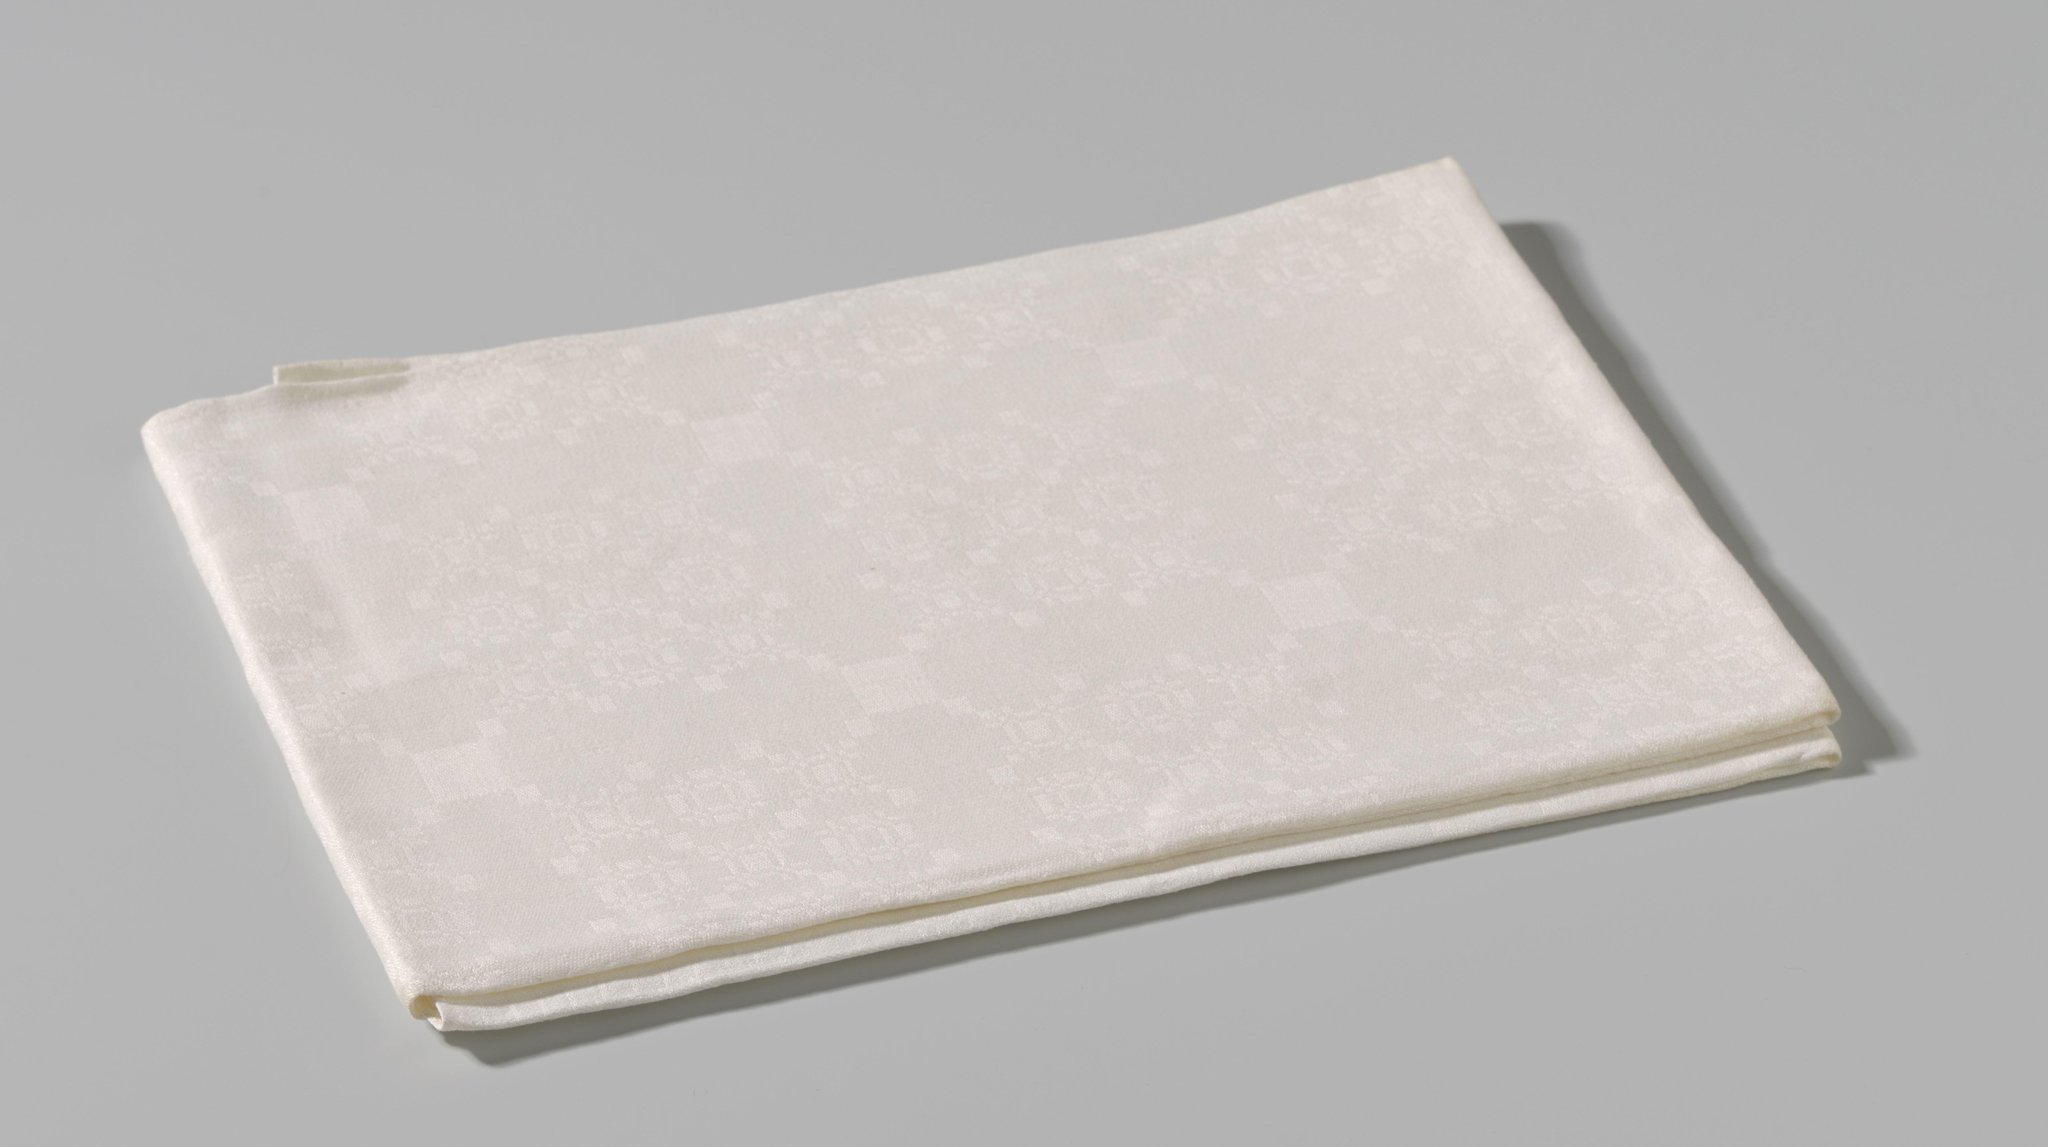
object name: napkin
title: Servet van linnen met pellenpatroon en randen rondom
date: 1700-1799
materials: linen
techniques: peeled fabric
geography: netherlands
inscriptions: mark: ‘WS’, mark: ‘100’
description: Servet van linnen met pellenpatroon en randen rondom. Een blok van drie maal drie pellen, om en om beeld en tegenbeeld, met een blok op de hoeken van drie patronen. Op de hoeken van deze figuren een reuze 'speldenkussen'. Merken: oorspronkelijk blauwe kruissteek WS en 100.